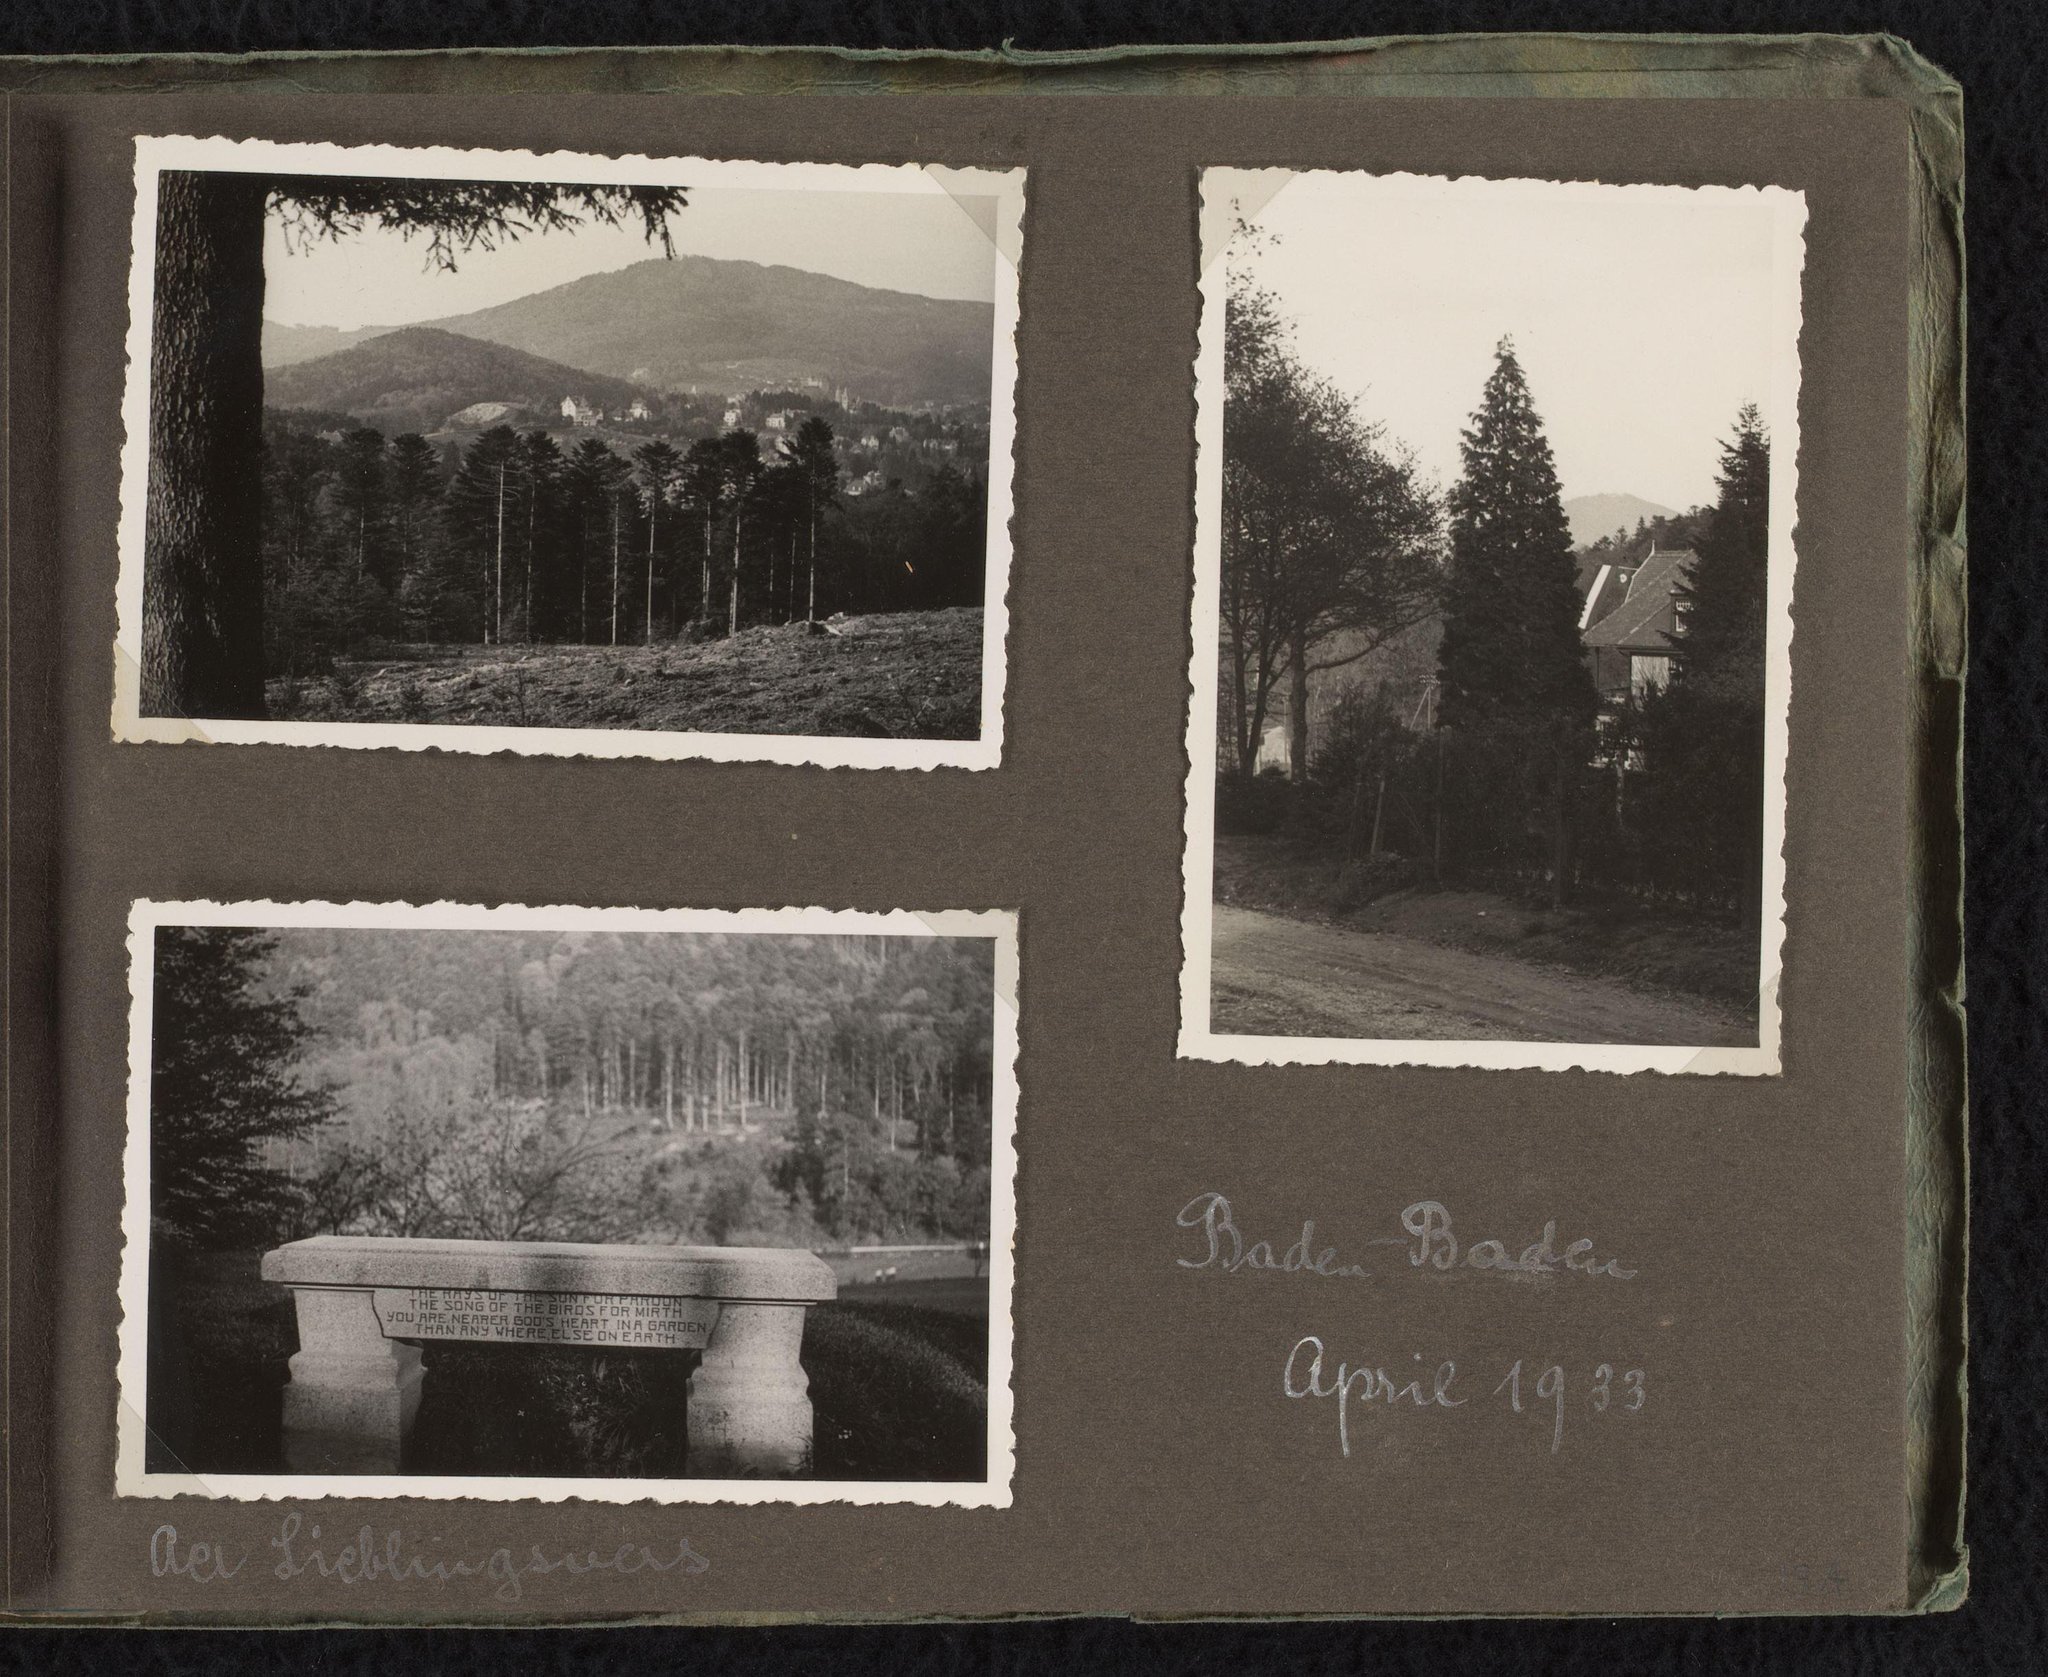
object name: photograph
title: Berglandschap, huis en bankje met vers, april 1933, Baden-Baden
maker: else wachenheimer-moos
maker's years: 1895-1944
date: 1904-1933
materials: paper, photographic support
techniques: gelatin silver print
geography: baden-baden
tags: the family travelling, on holiday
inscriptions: inscription: ‘... Lieblingsvers / Baden-Baden April 1933’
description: Blad bevat drie foto's. Alle foto's van oom Stephan. Uit het album, half formaat, groen geaderd kartonomslag met koordbinding.